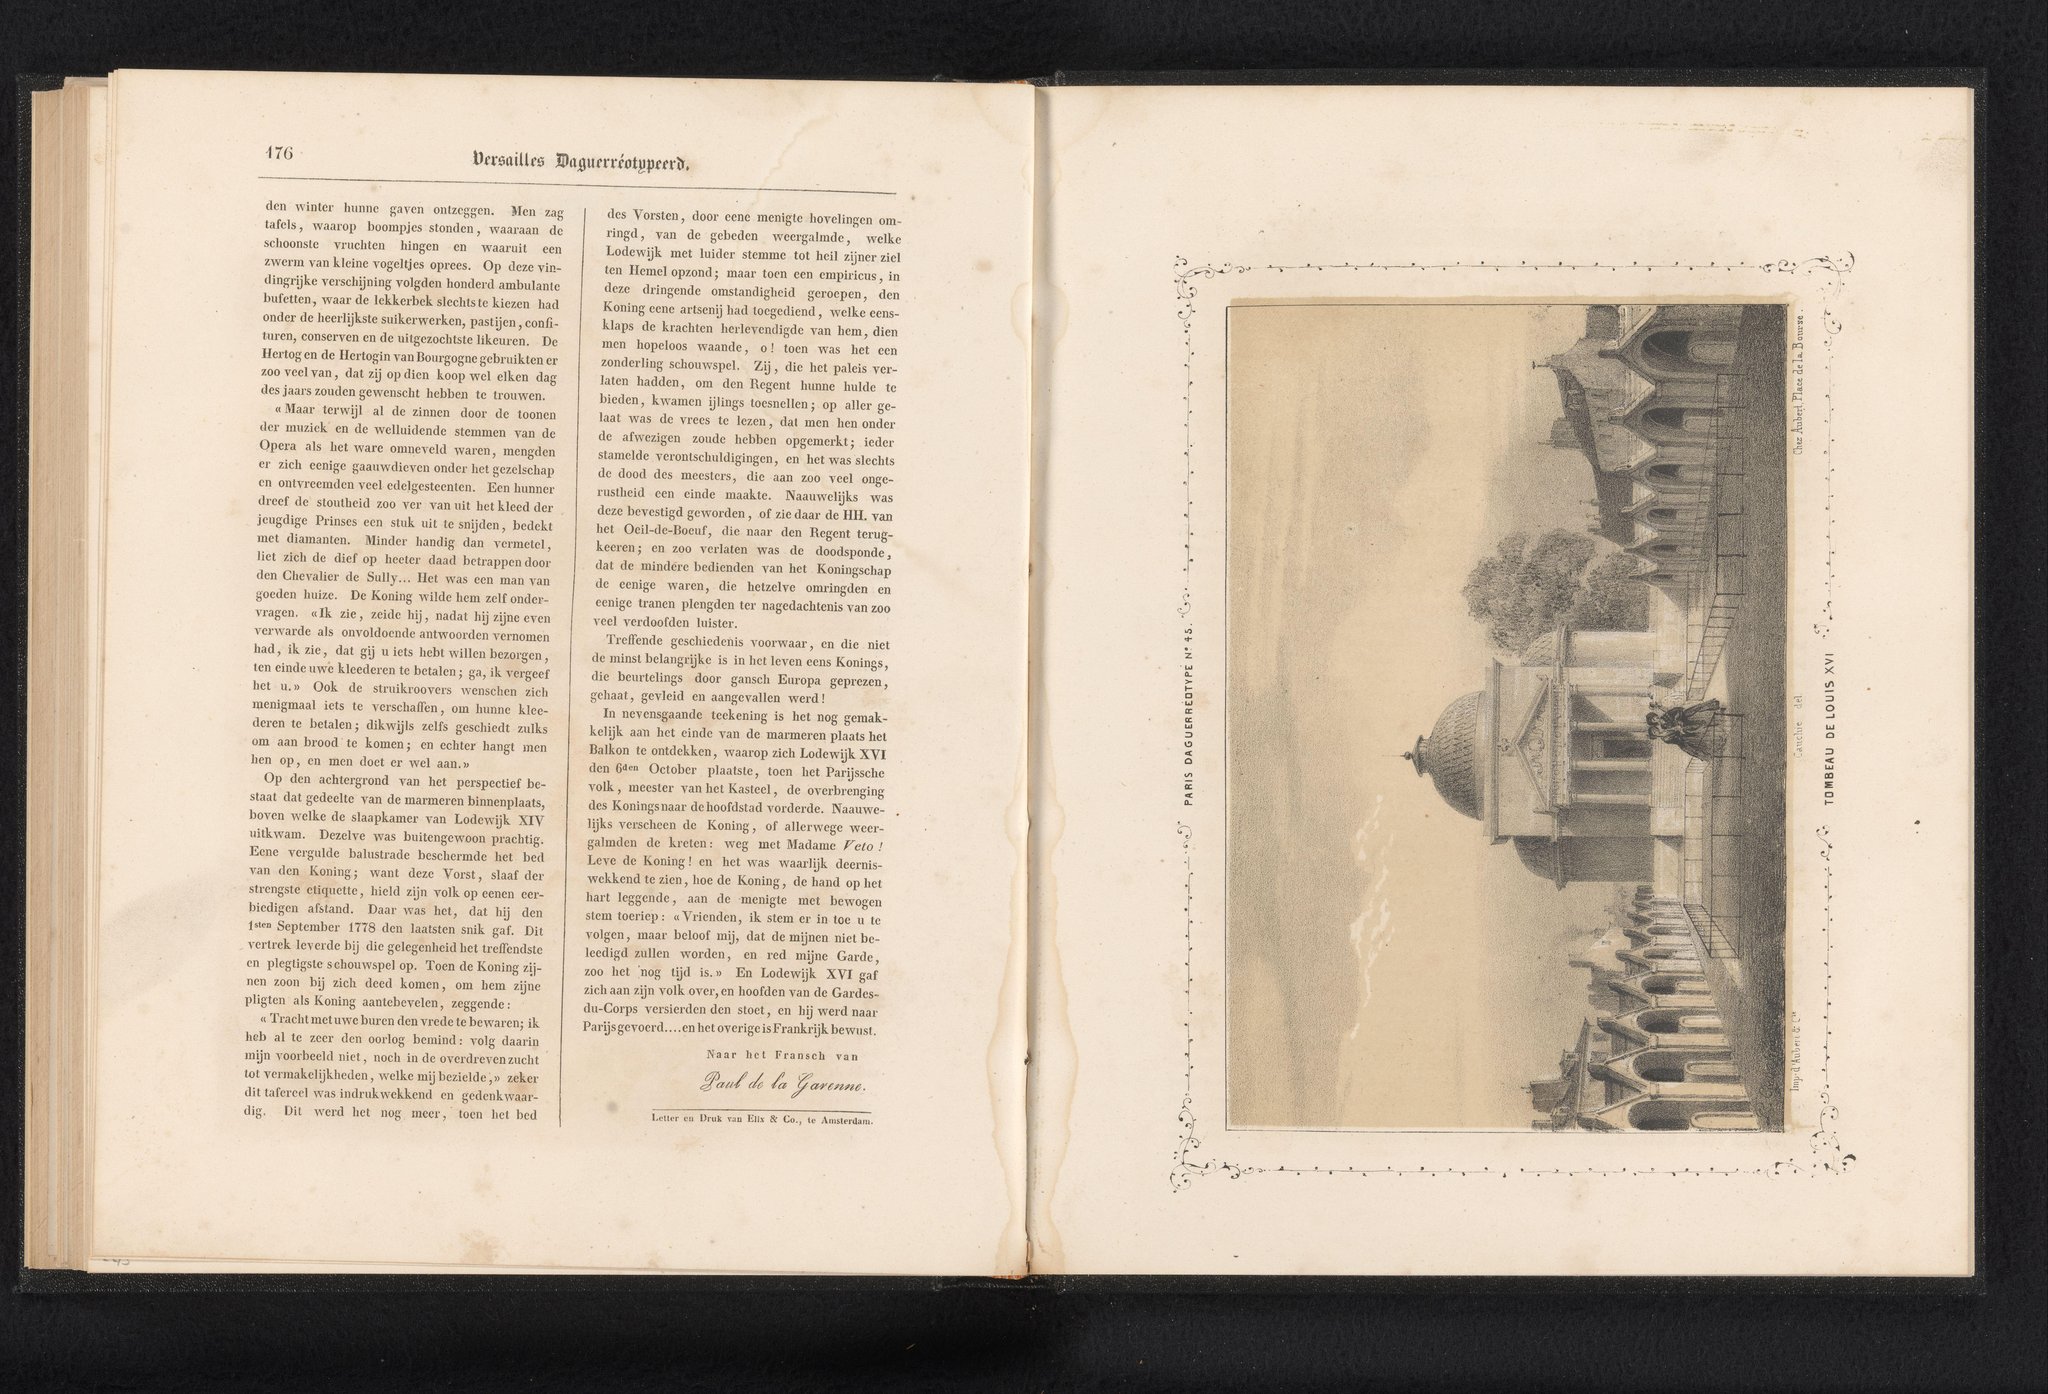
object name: page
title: Tombeau de Louis XVI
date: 1839-1840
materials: paper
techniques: tone lithography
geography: paris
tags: square, place, circus, etc.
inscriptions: inscription: ‘PARIS DAGUERRÉOTYPÉ No. 45.’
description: Prent op honderdnegenenzeventigste ongenummerde pagina.